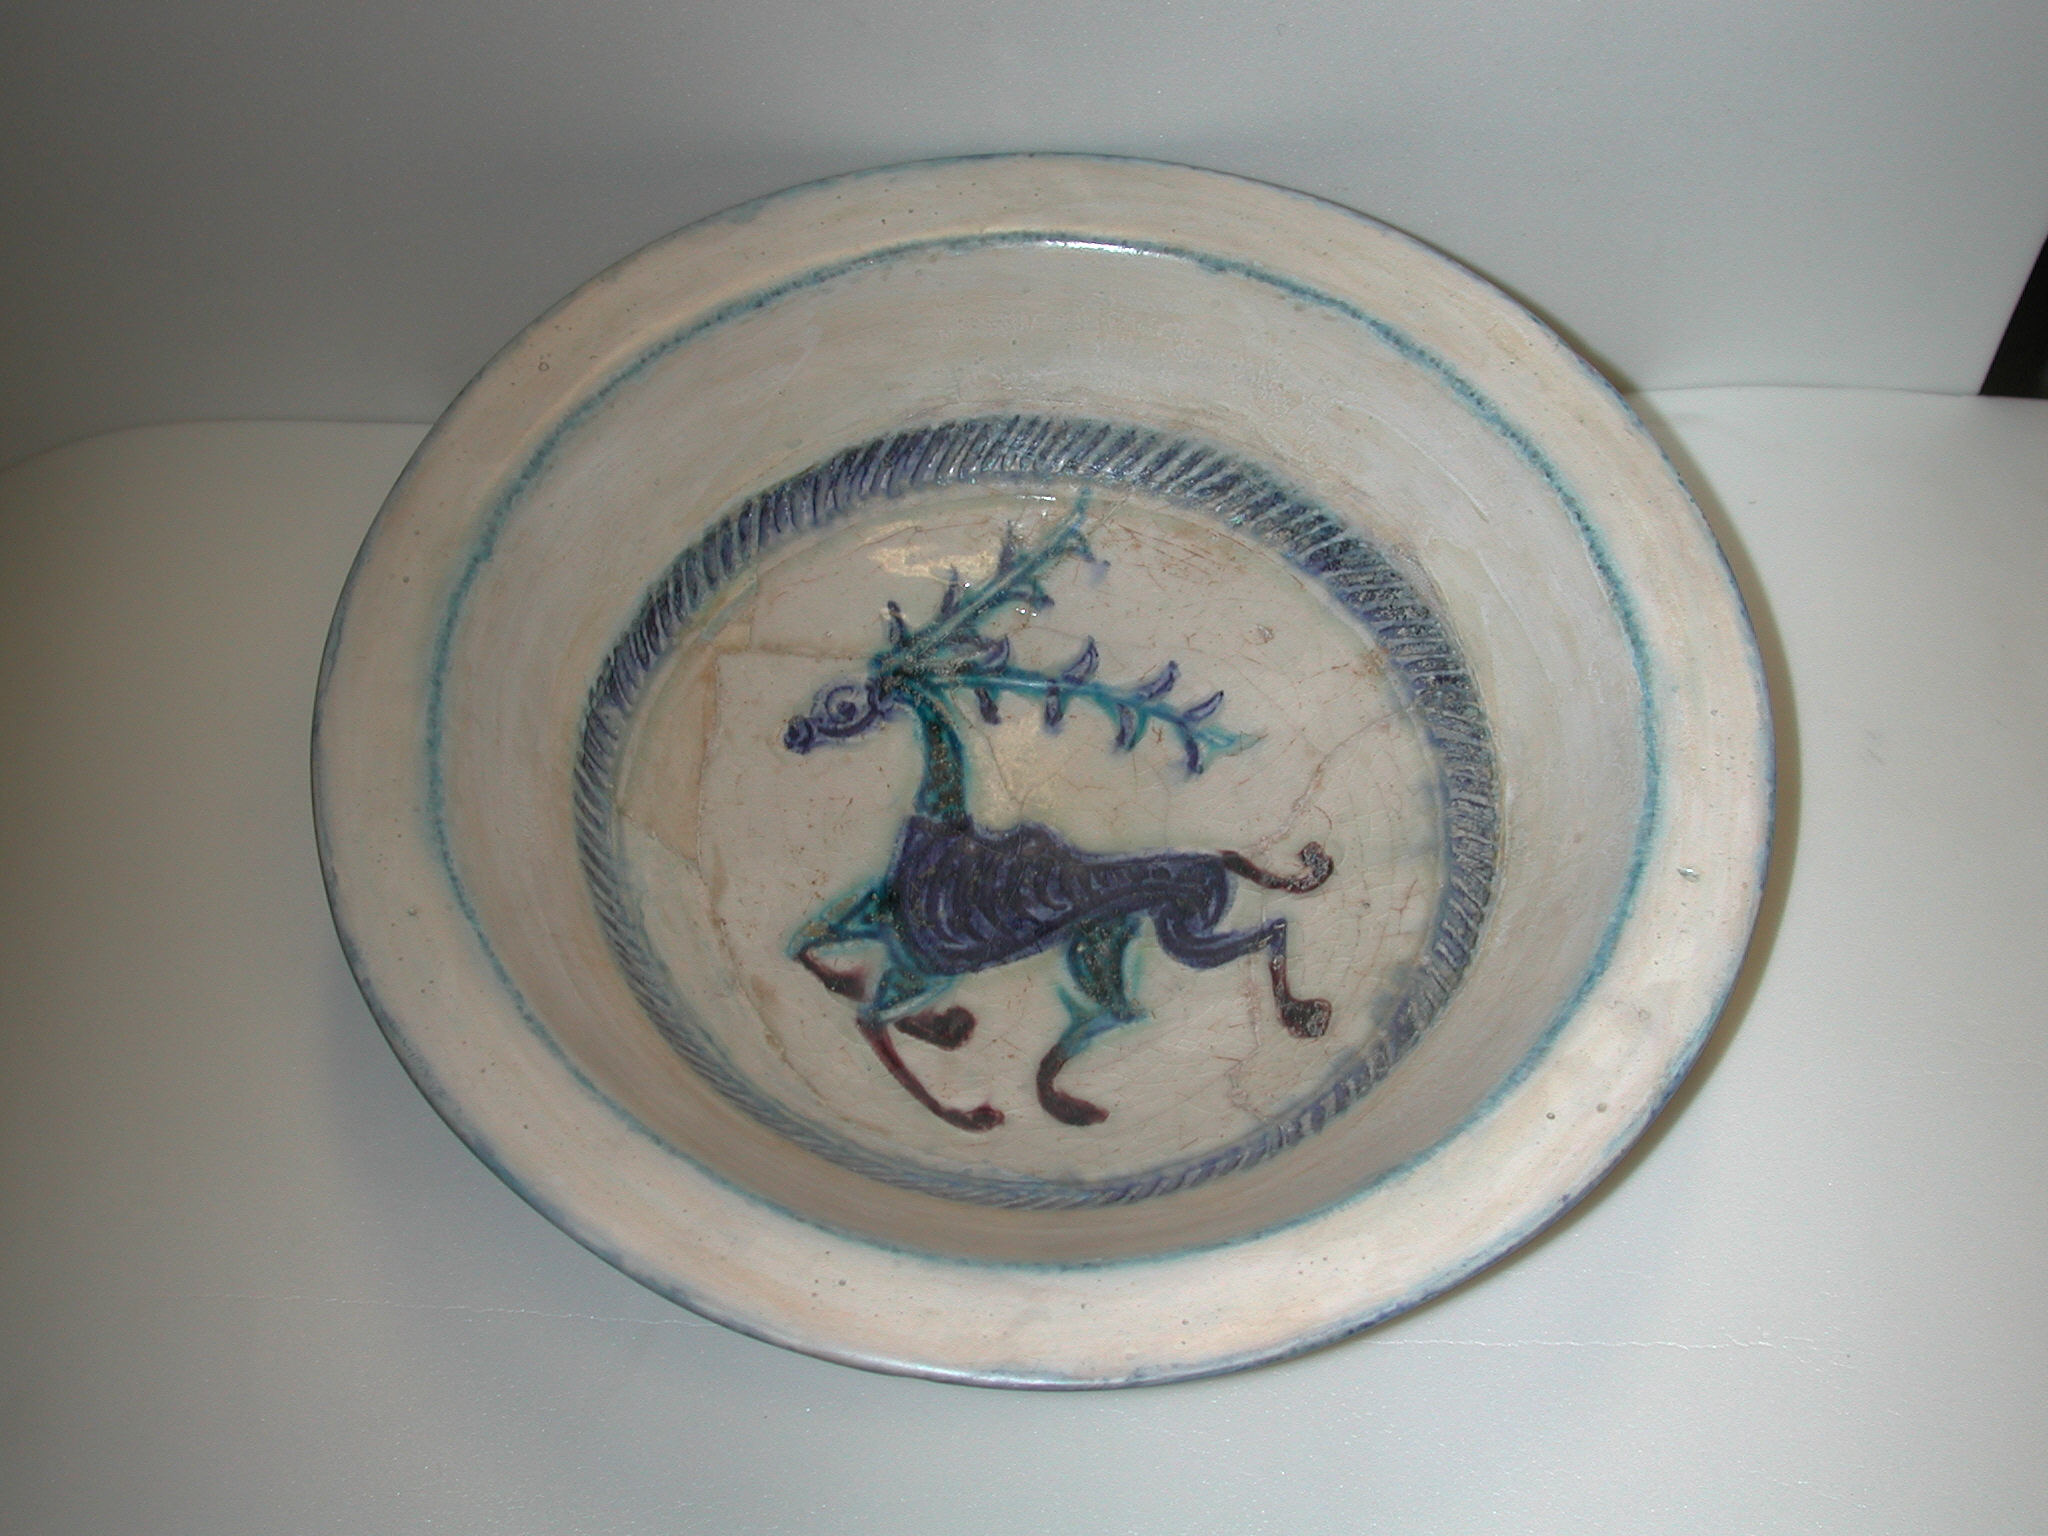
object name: bowl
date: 1151-1200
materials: glaze, stonepaste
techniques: incising, painting, underglaze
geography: syria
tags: deer